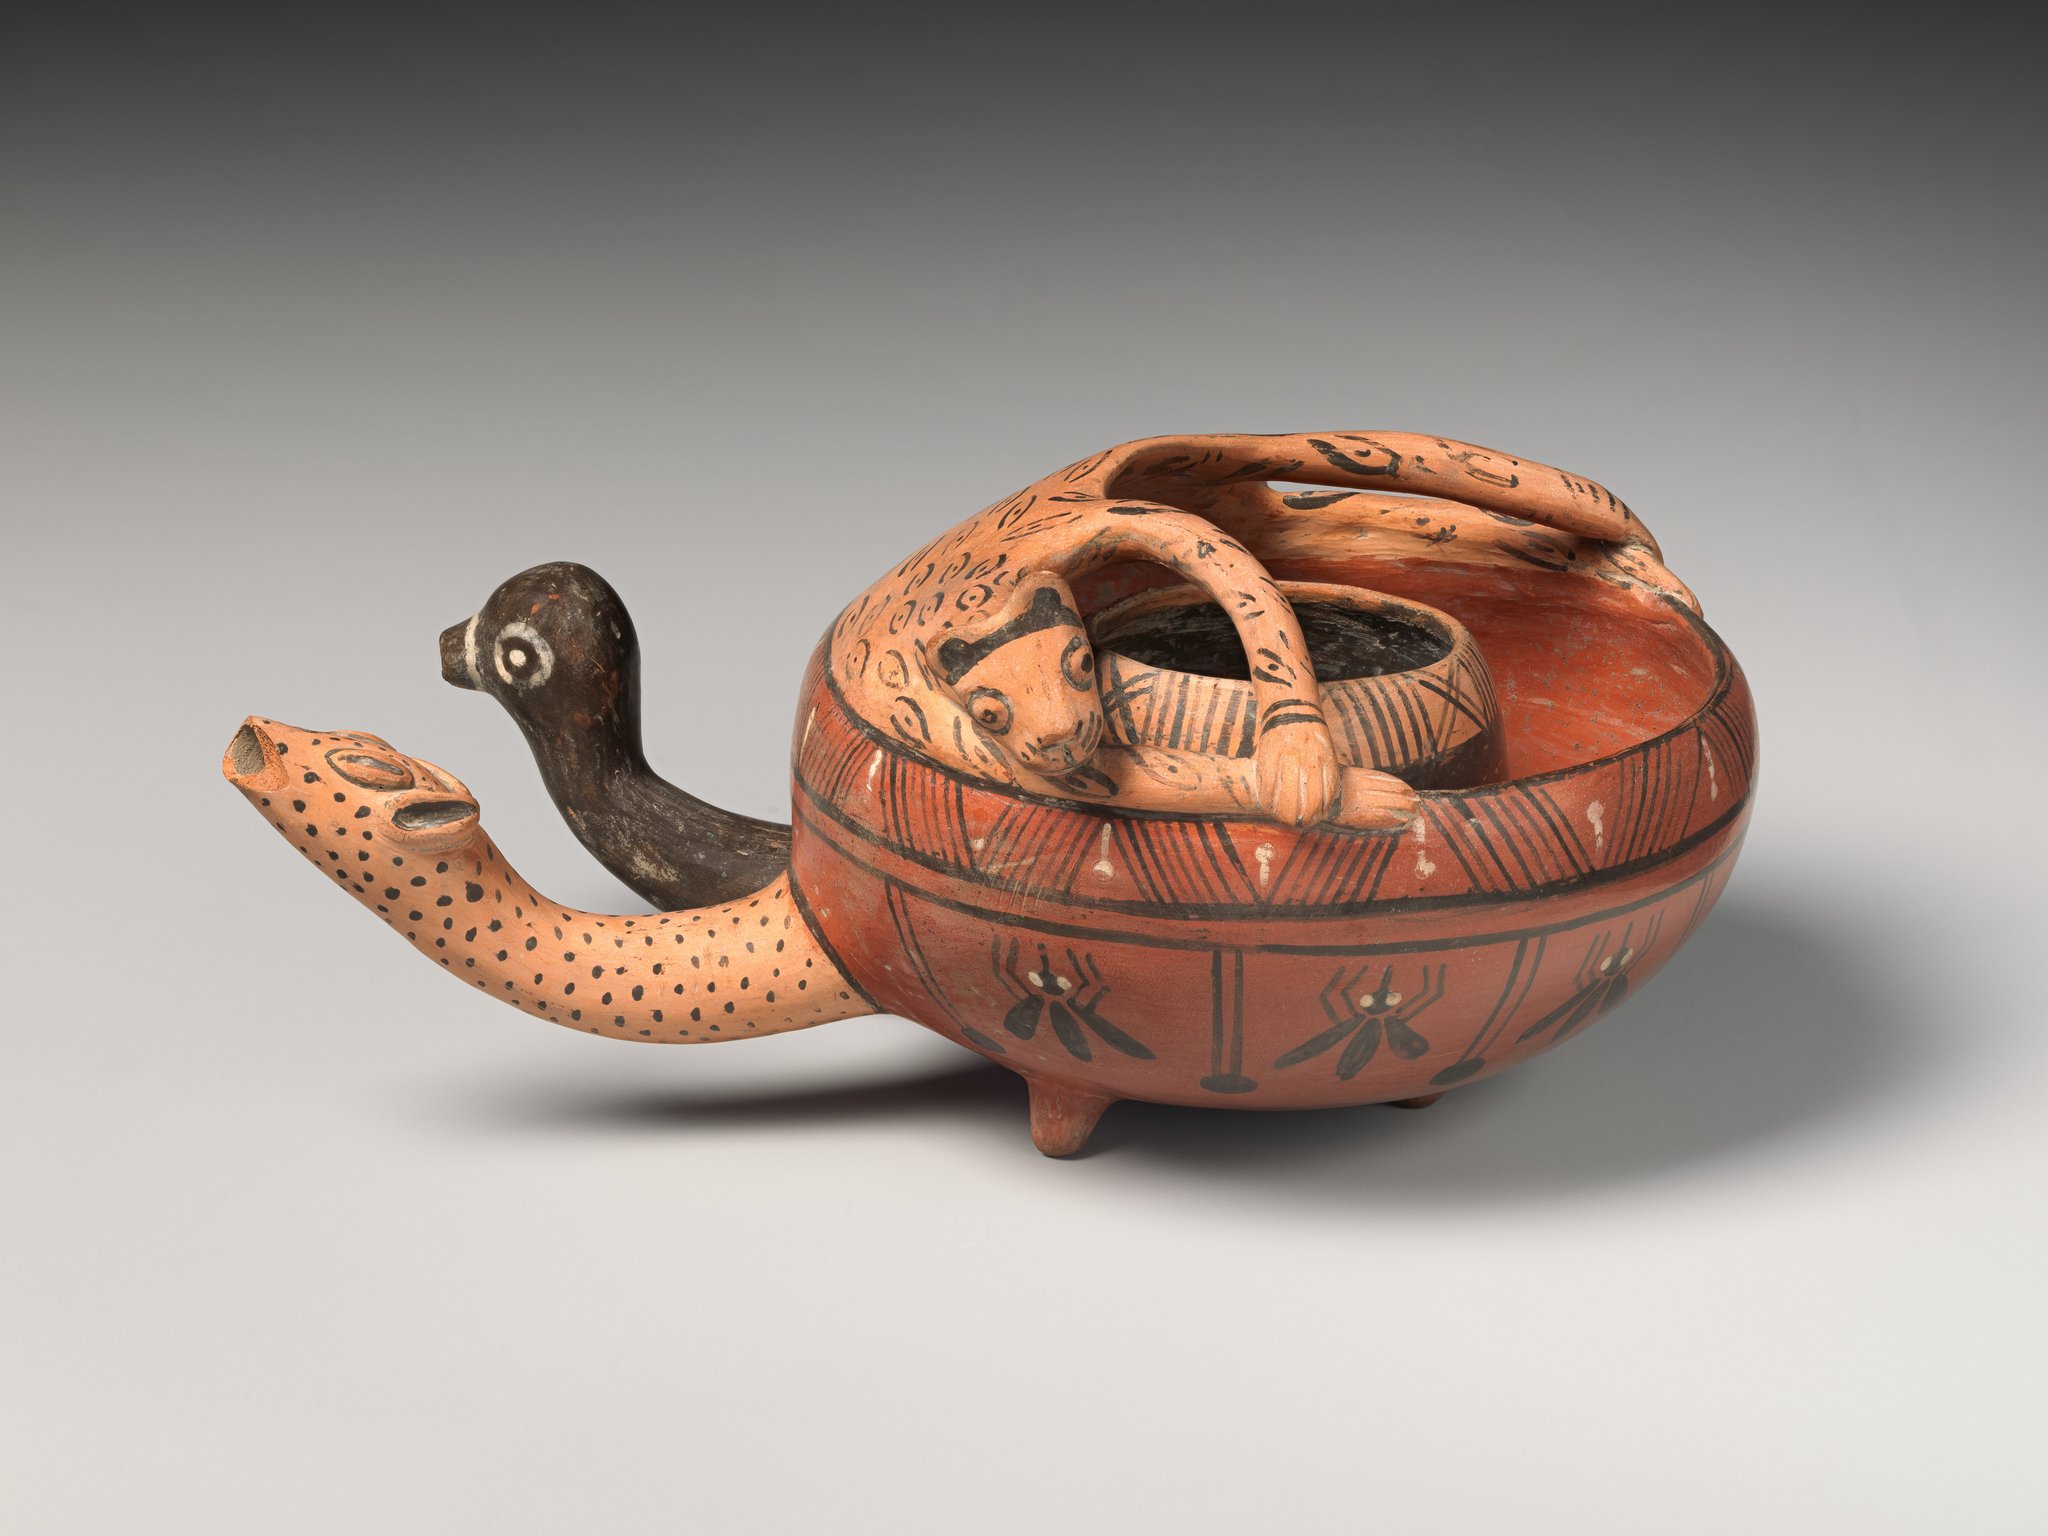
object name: bowl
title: Double bowl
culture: inca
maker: inca artist(s)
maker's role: artist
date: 1400-1535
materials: ceramic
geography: peru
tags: animals,birds